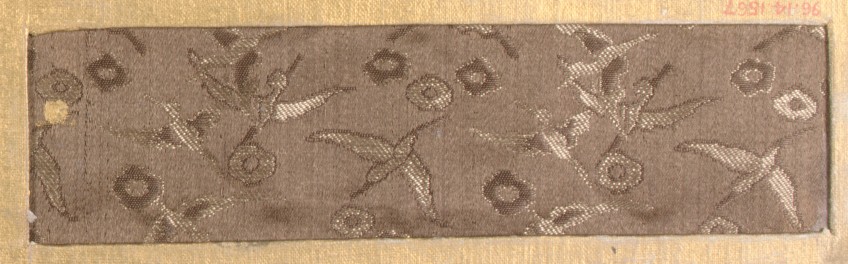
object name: piece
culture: japanese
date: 1701-1900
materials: silk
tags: birds